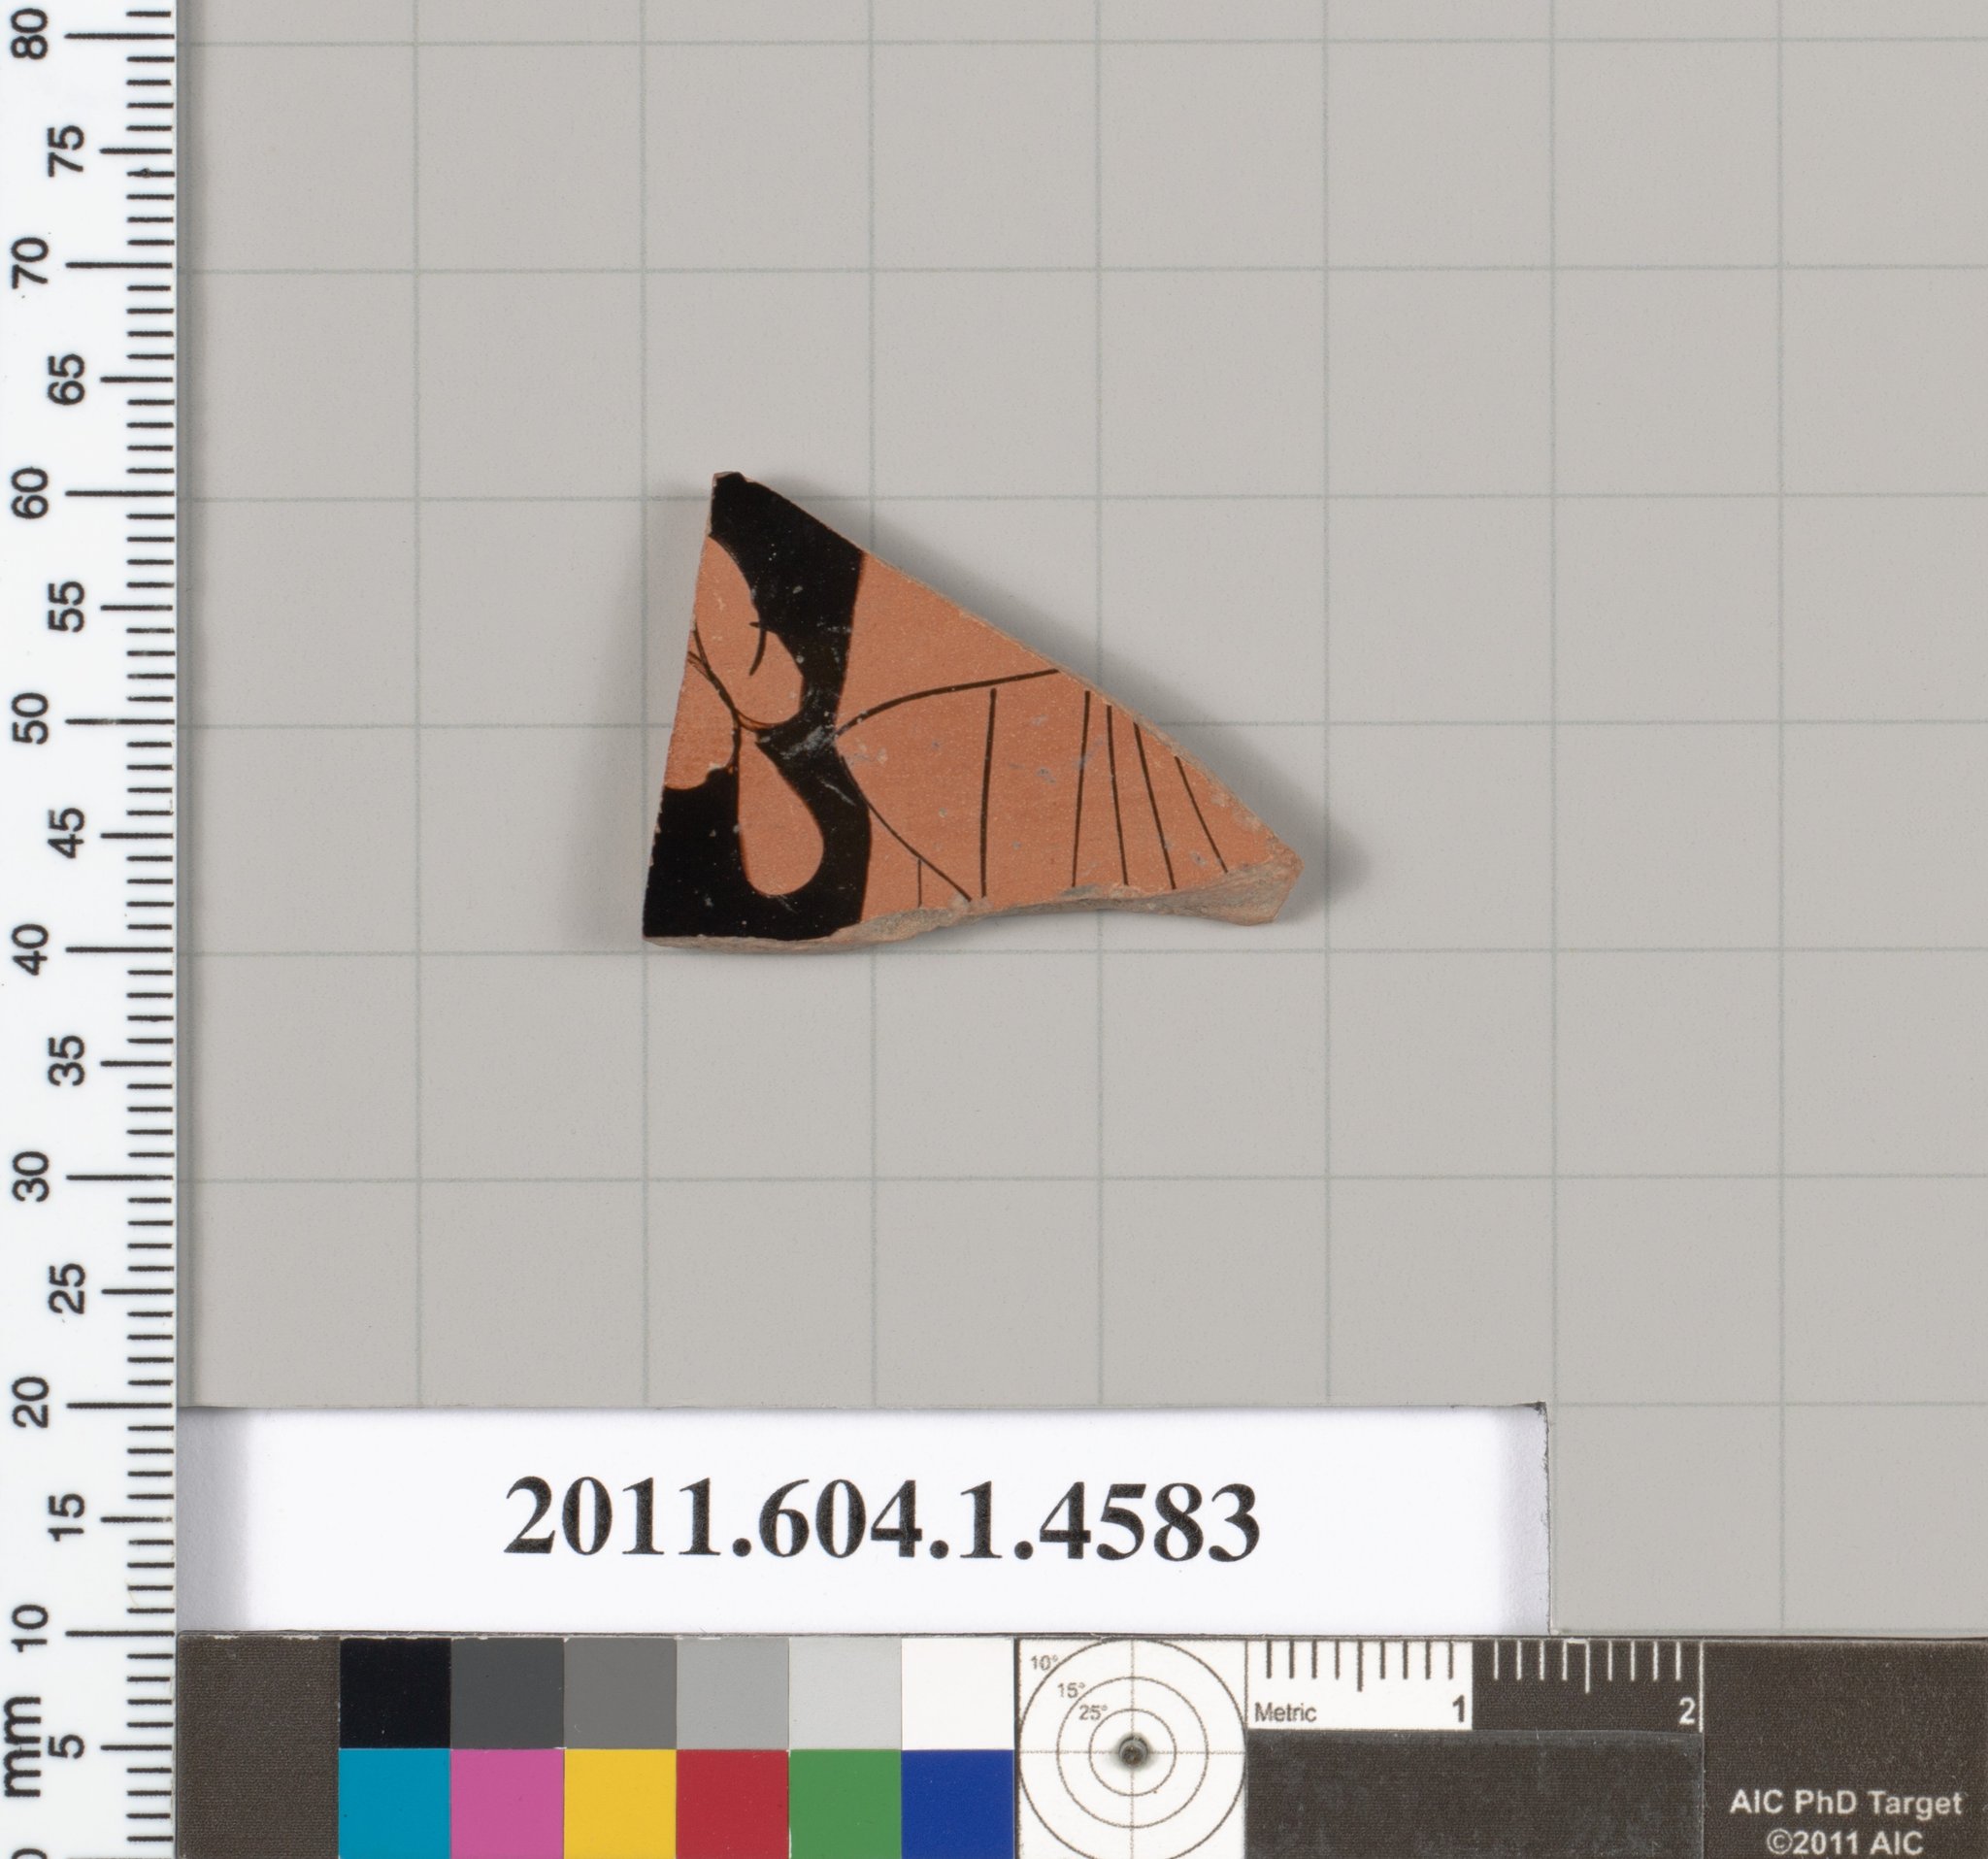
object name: kylix fragment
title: Terracotta fragment of a kylix (drinking cup)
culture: greek, attic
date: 490-470 BCE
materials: terracotta